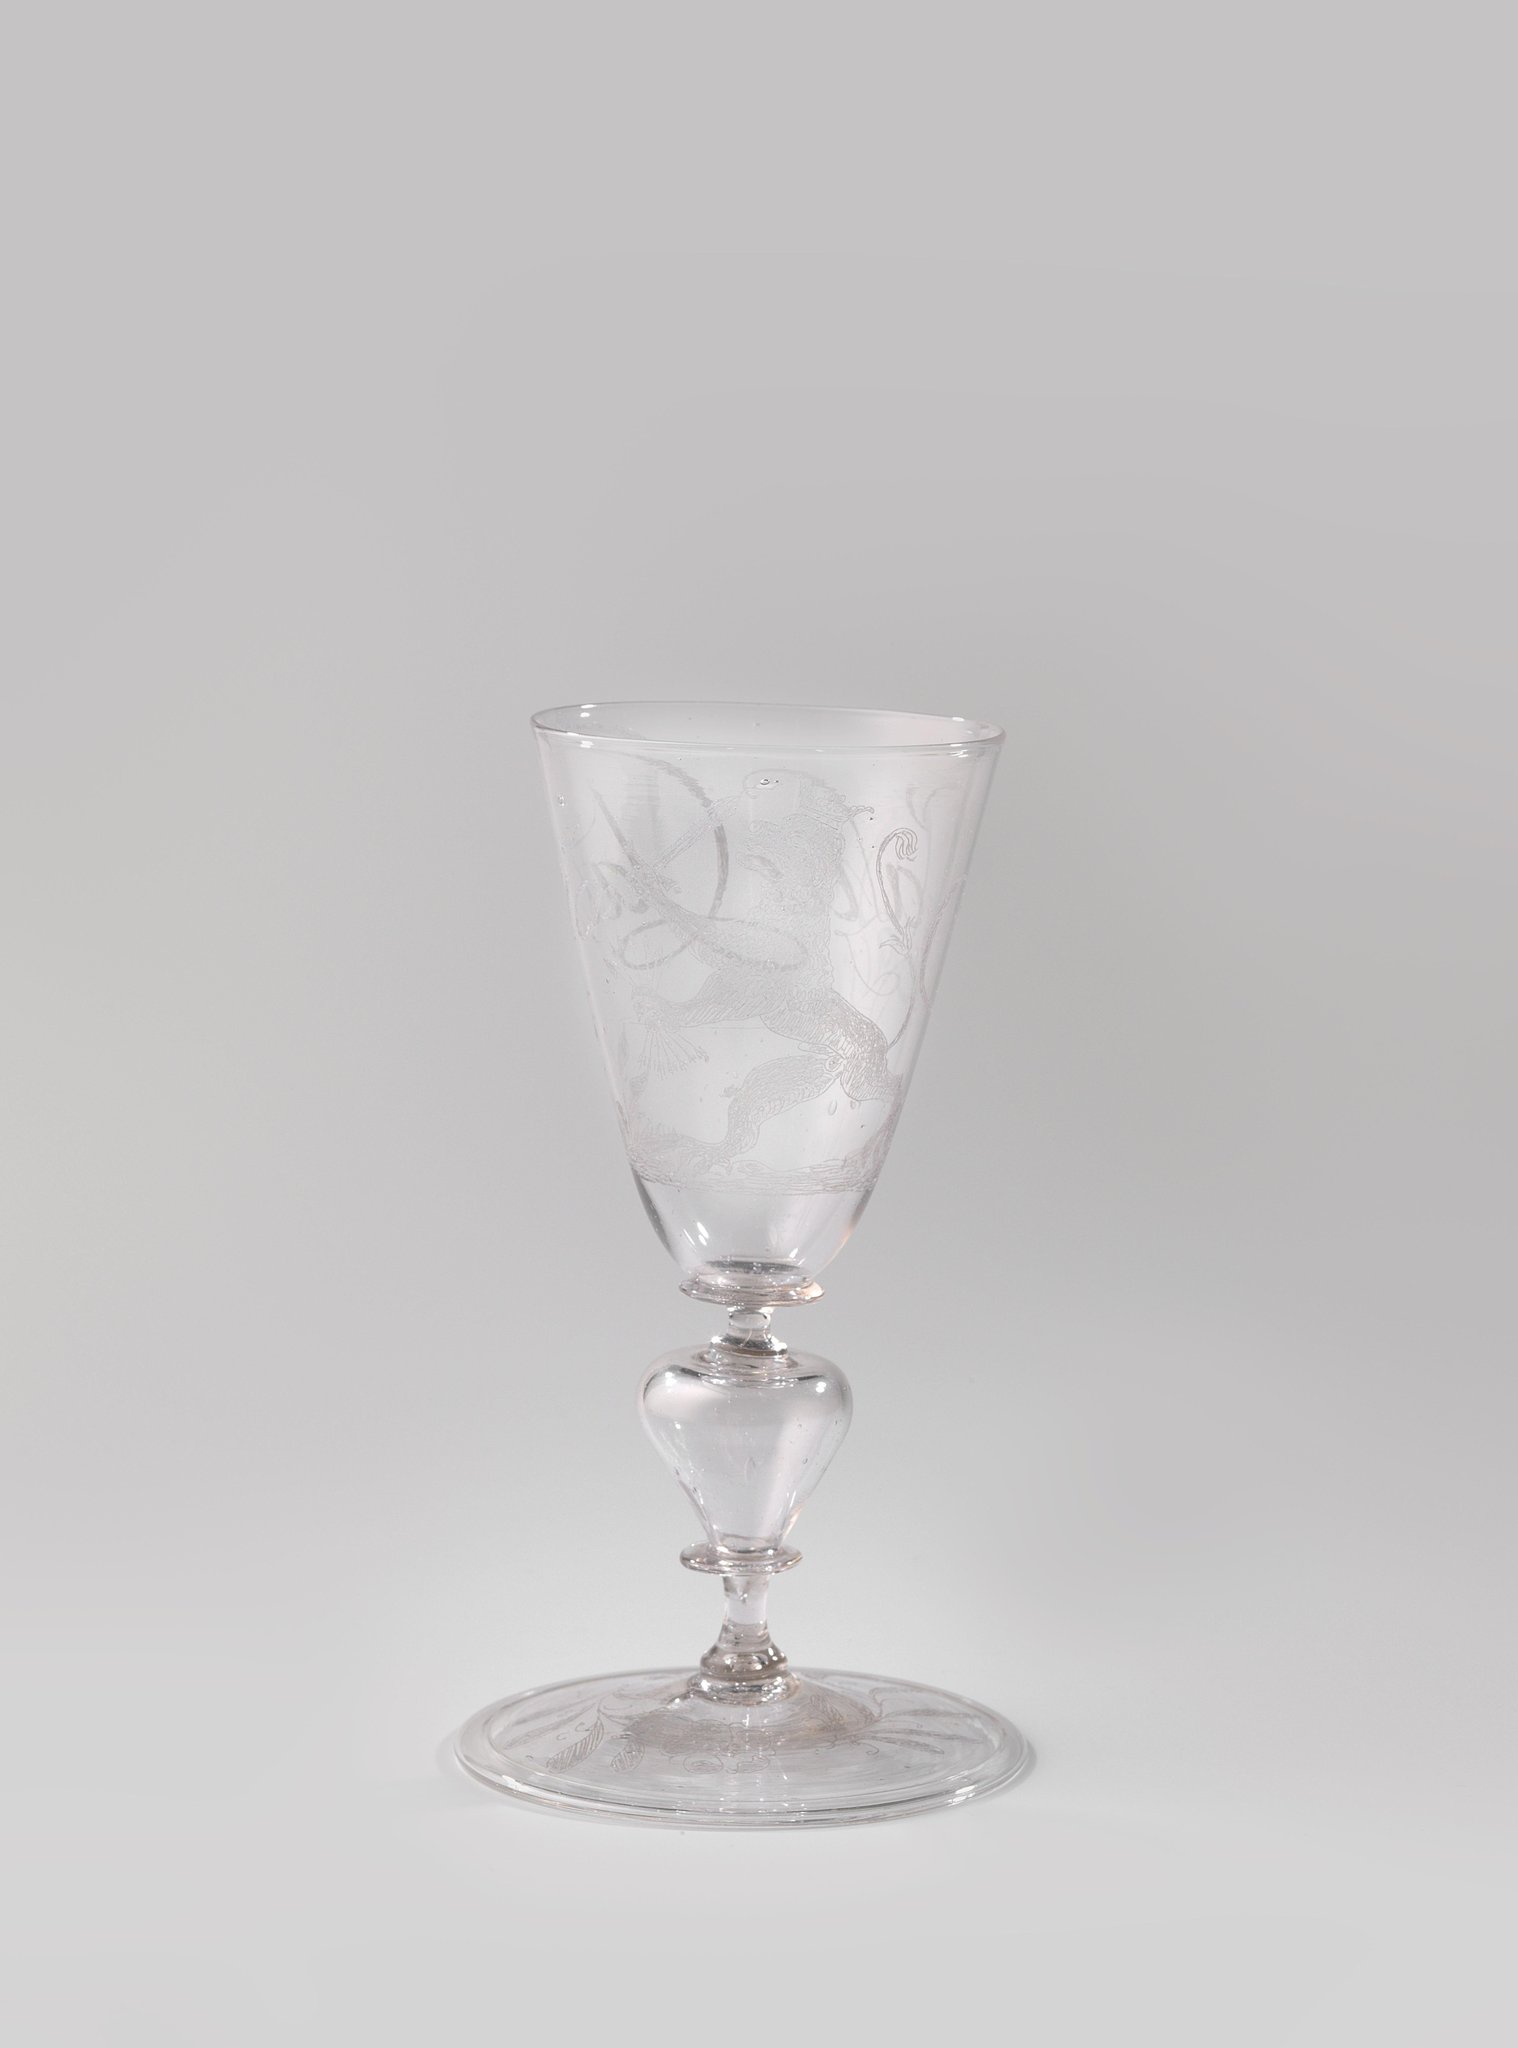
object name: goblet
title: Kelkglas met de leeuw van de Republiek der Verenigde Nederlanden en het opschrift: Salus Patriae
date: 1675-1700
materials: glass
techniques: diamond point engraving, façon de venise, glassblowing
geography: low countries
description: Platte voet met omgeslagen rand en pontilmerk. Holle, balustervormige stam met twee platte schijven. Trechtervormige, aan de onderzijde afgeronde kelk. Op de kelk is de leeuw van de Republiek der Verenigde Nederlanden gegraveerd. Op de keerzijde het opschrift 'Salus Patriae' (het welzijn van het vaderland).